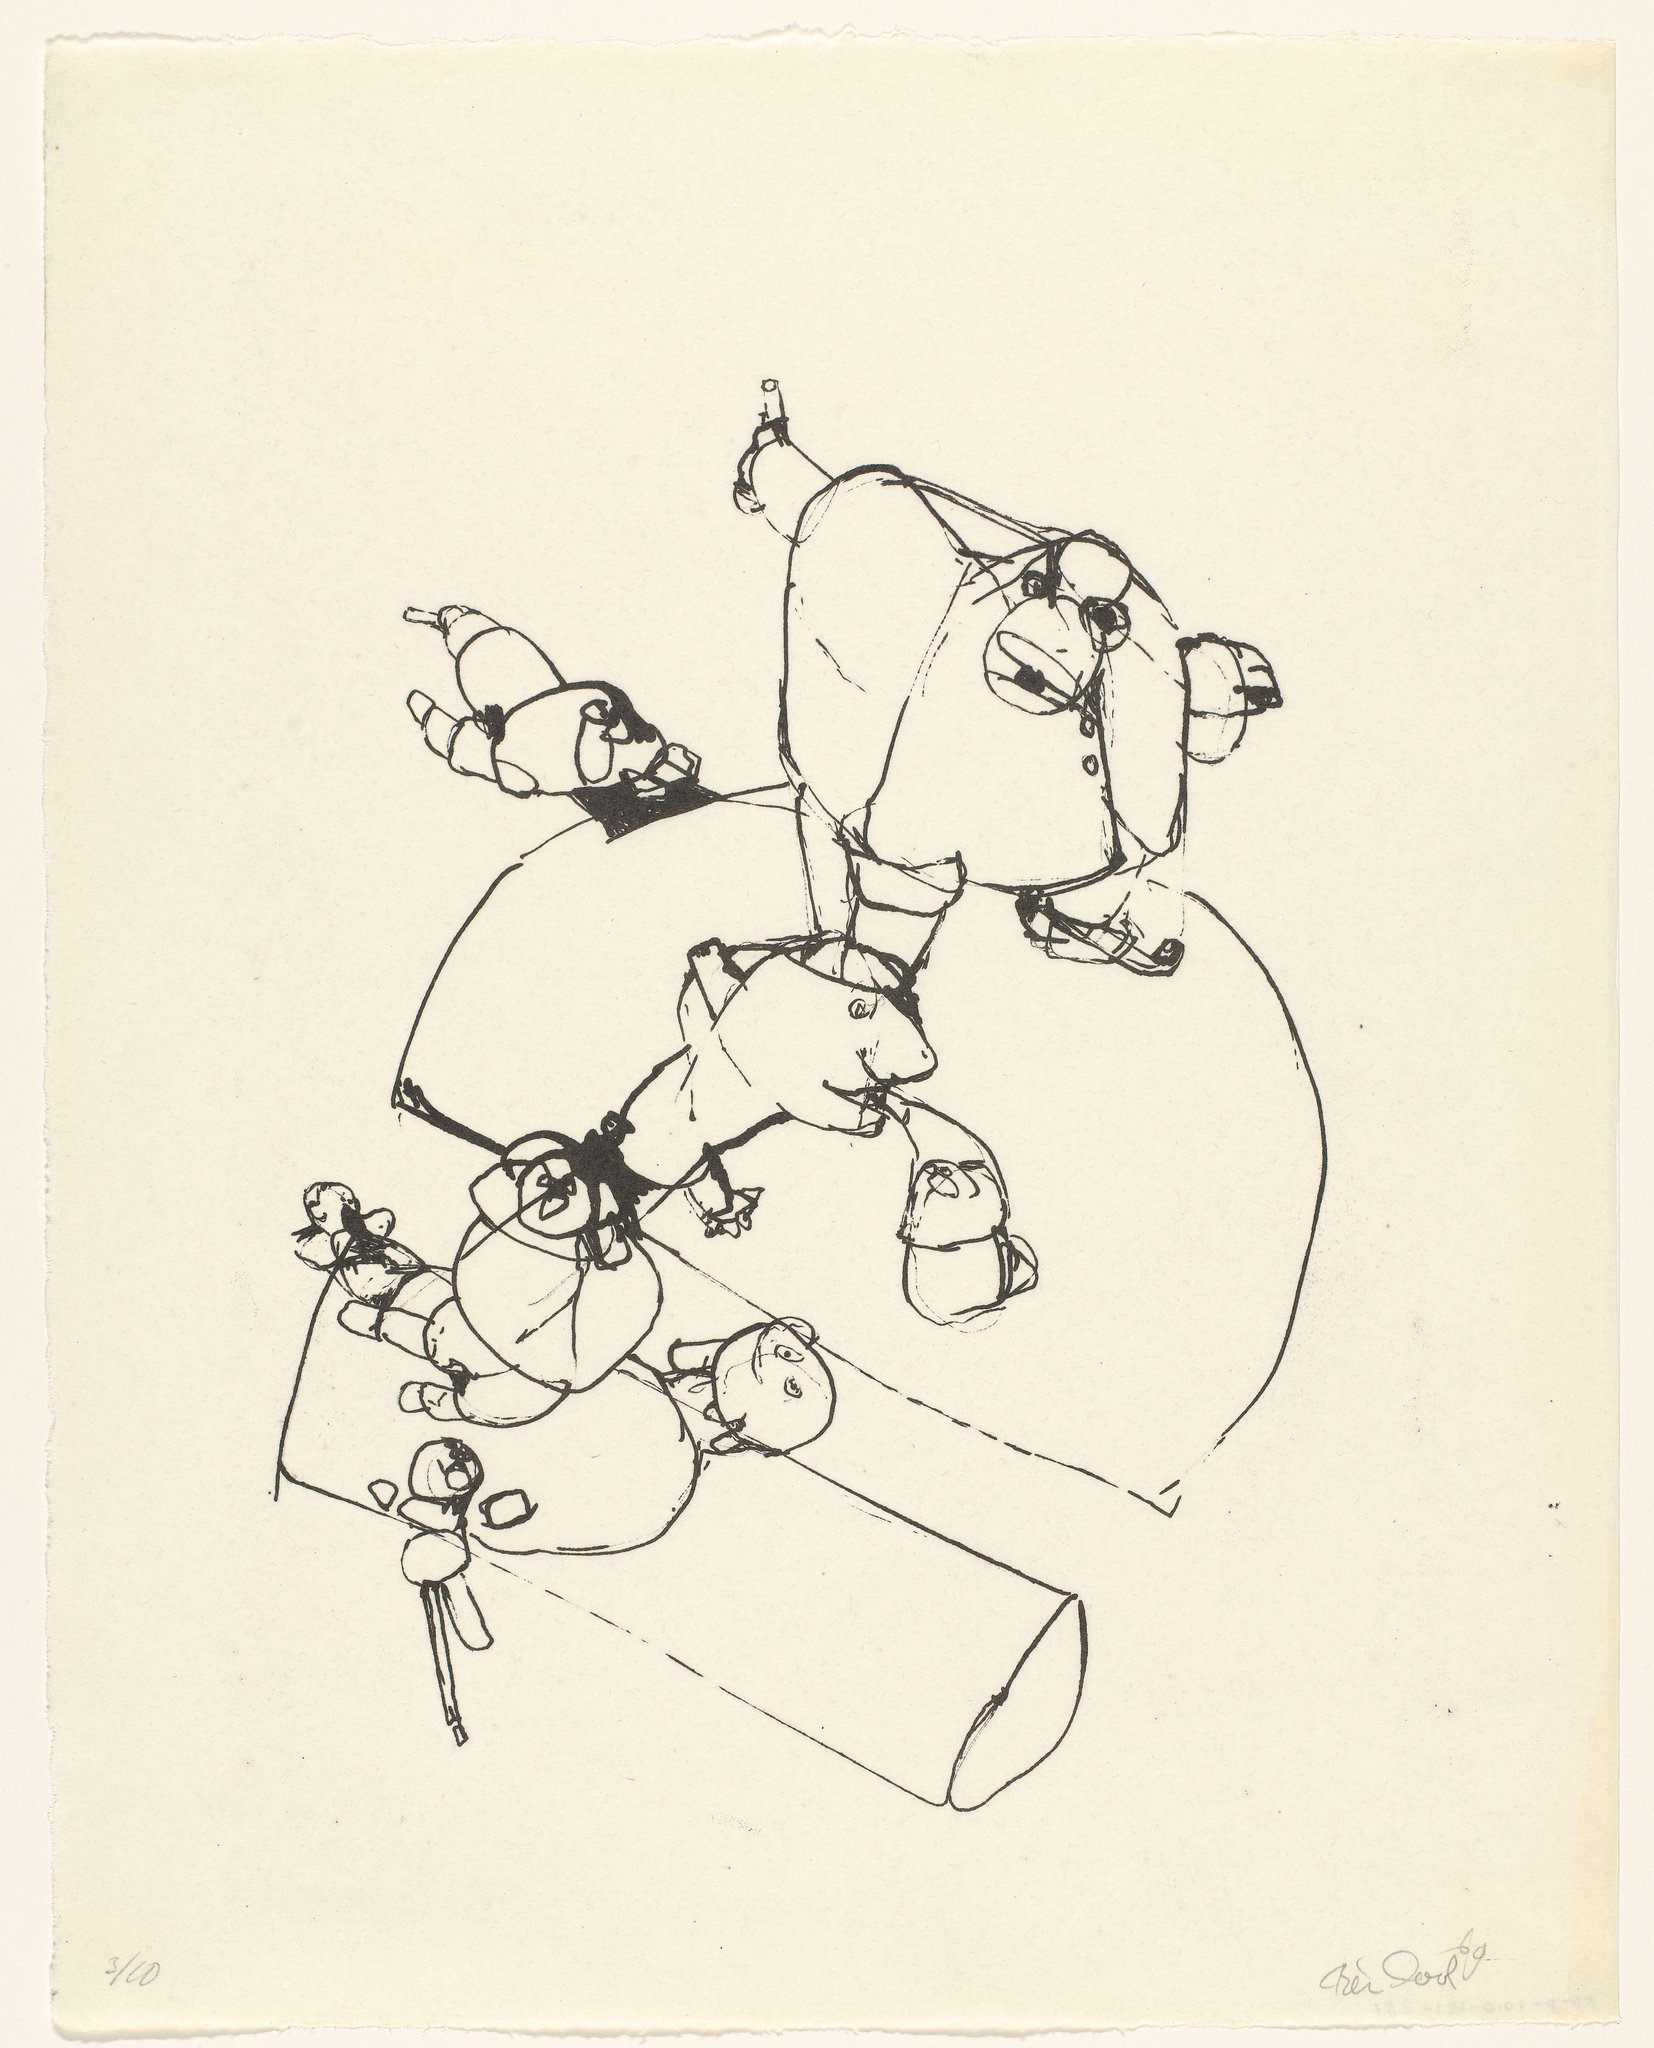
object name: print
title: Menselijke figuren, halve cirkel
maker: rein dool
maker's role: draughtsman, painter, print maker, sculptor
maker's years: 1933-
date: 1969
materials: paper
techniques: lithograph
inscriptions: signature and date: ‘Rein Dool 69’, edition: ‘3/10’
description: Menselijke figuren, de middelste brakend, op de achtergrond een halve cirkel een cilinder.